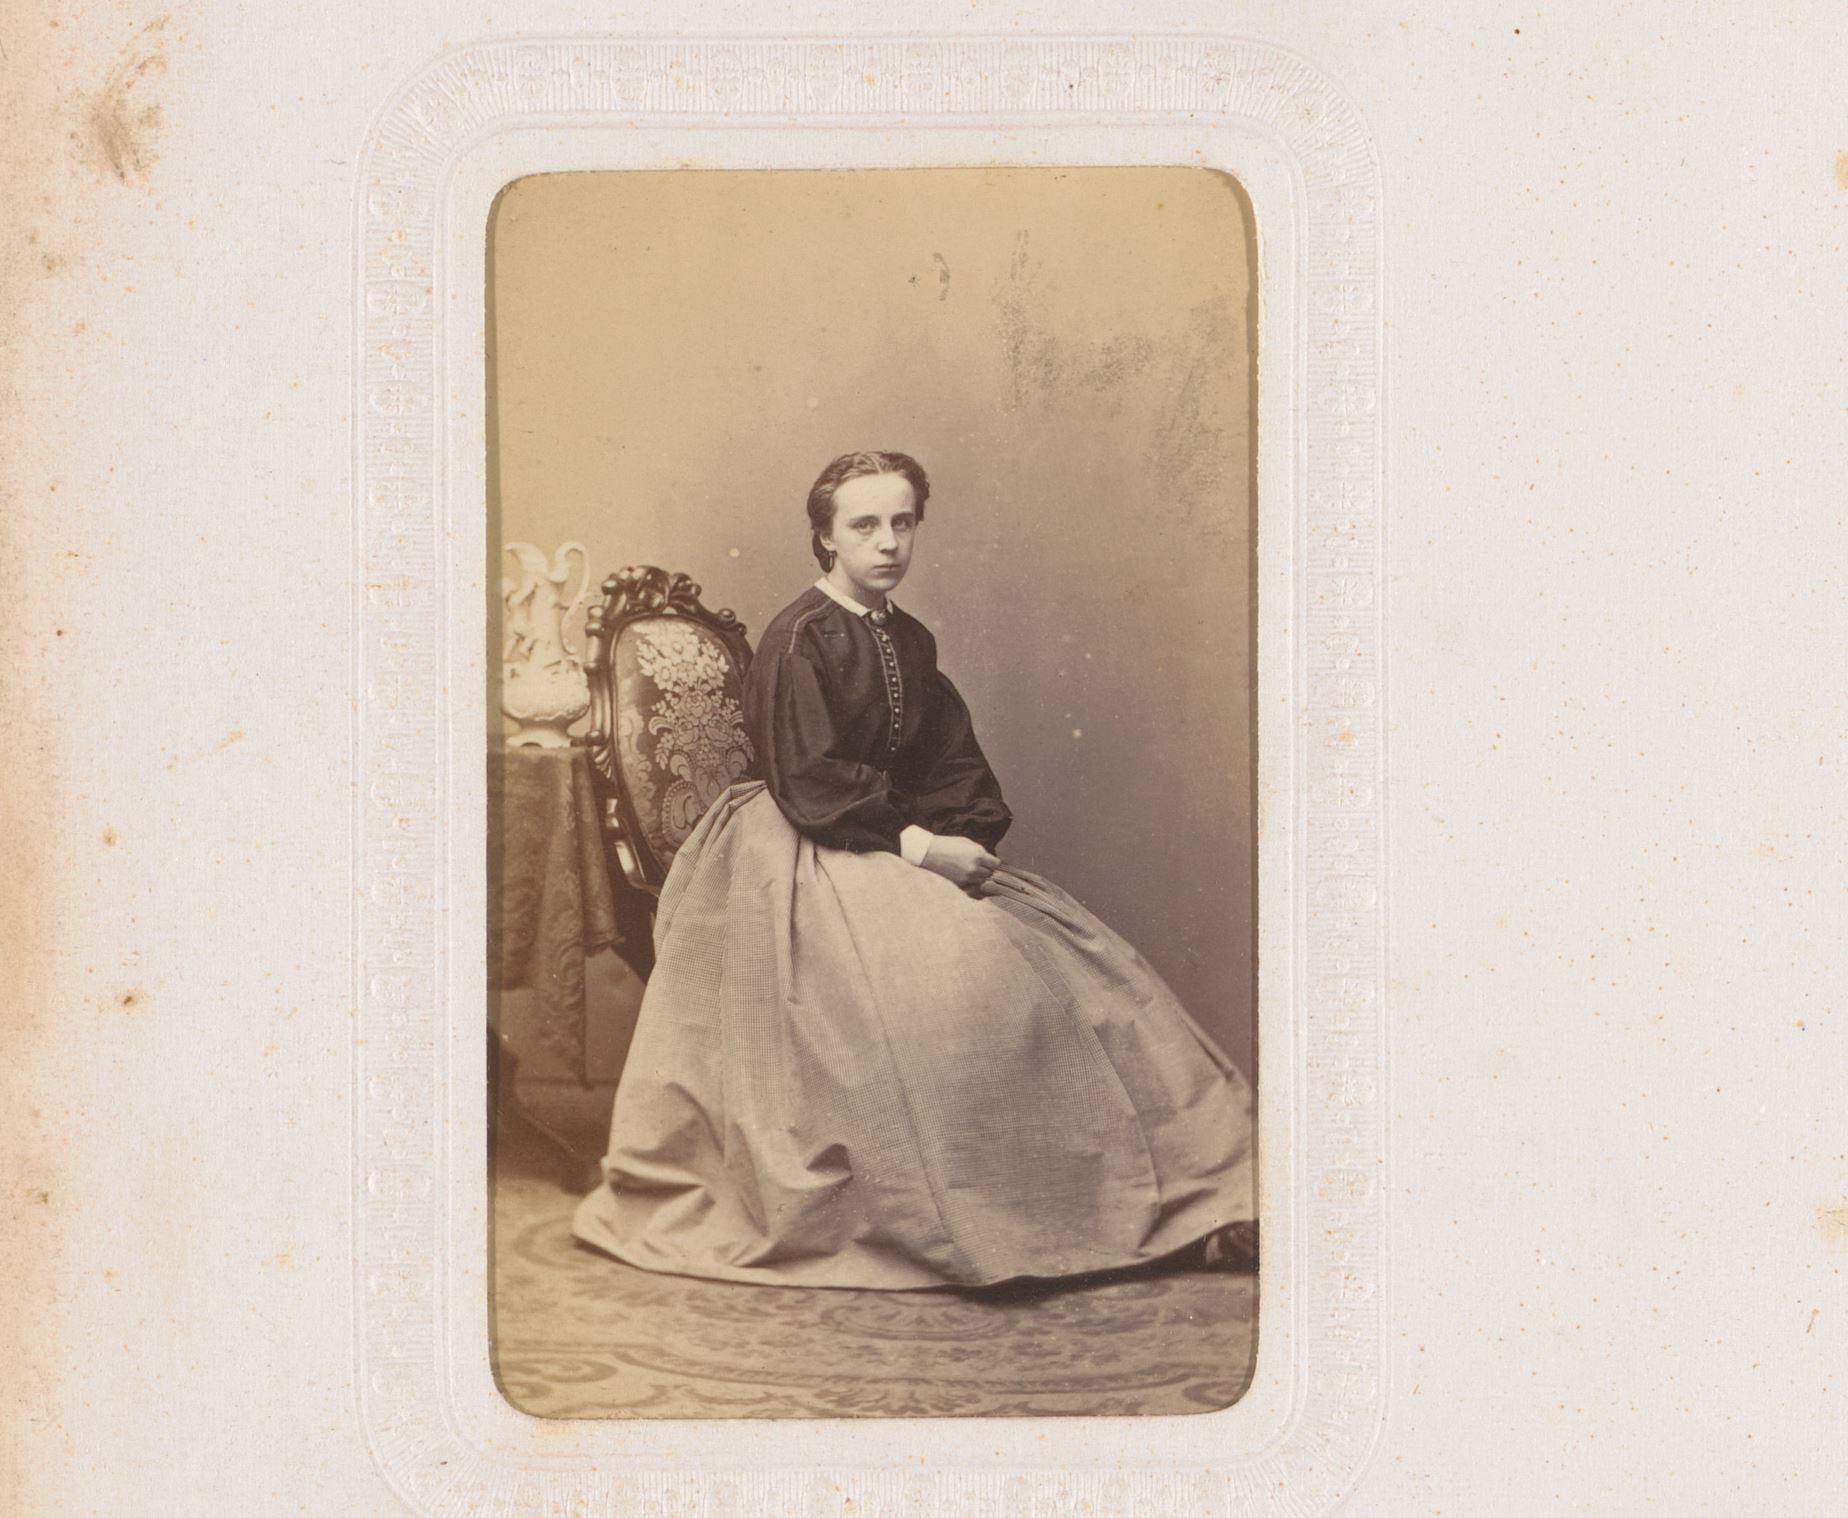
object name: album leaf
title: Portret van een zittende jonge vrouw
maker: Anonymous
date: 1860-1900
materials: cardboard, photographic support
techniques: albumen print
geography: netherlands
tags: adolescent, young woman, maiden, sitting figure - aa - female human figure, historical persons - bb - woman